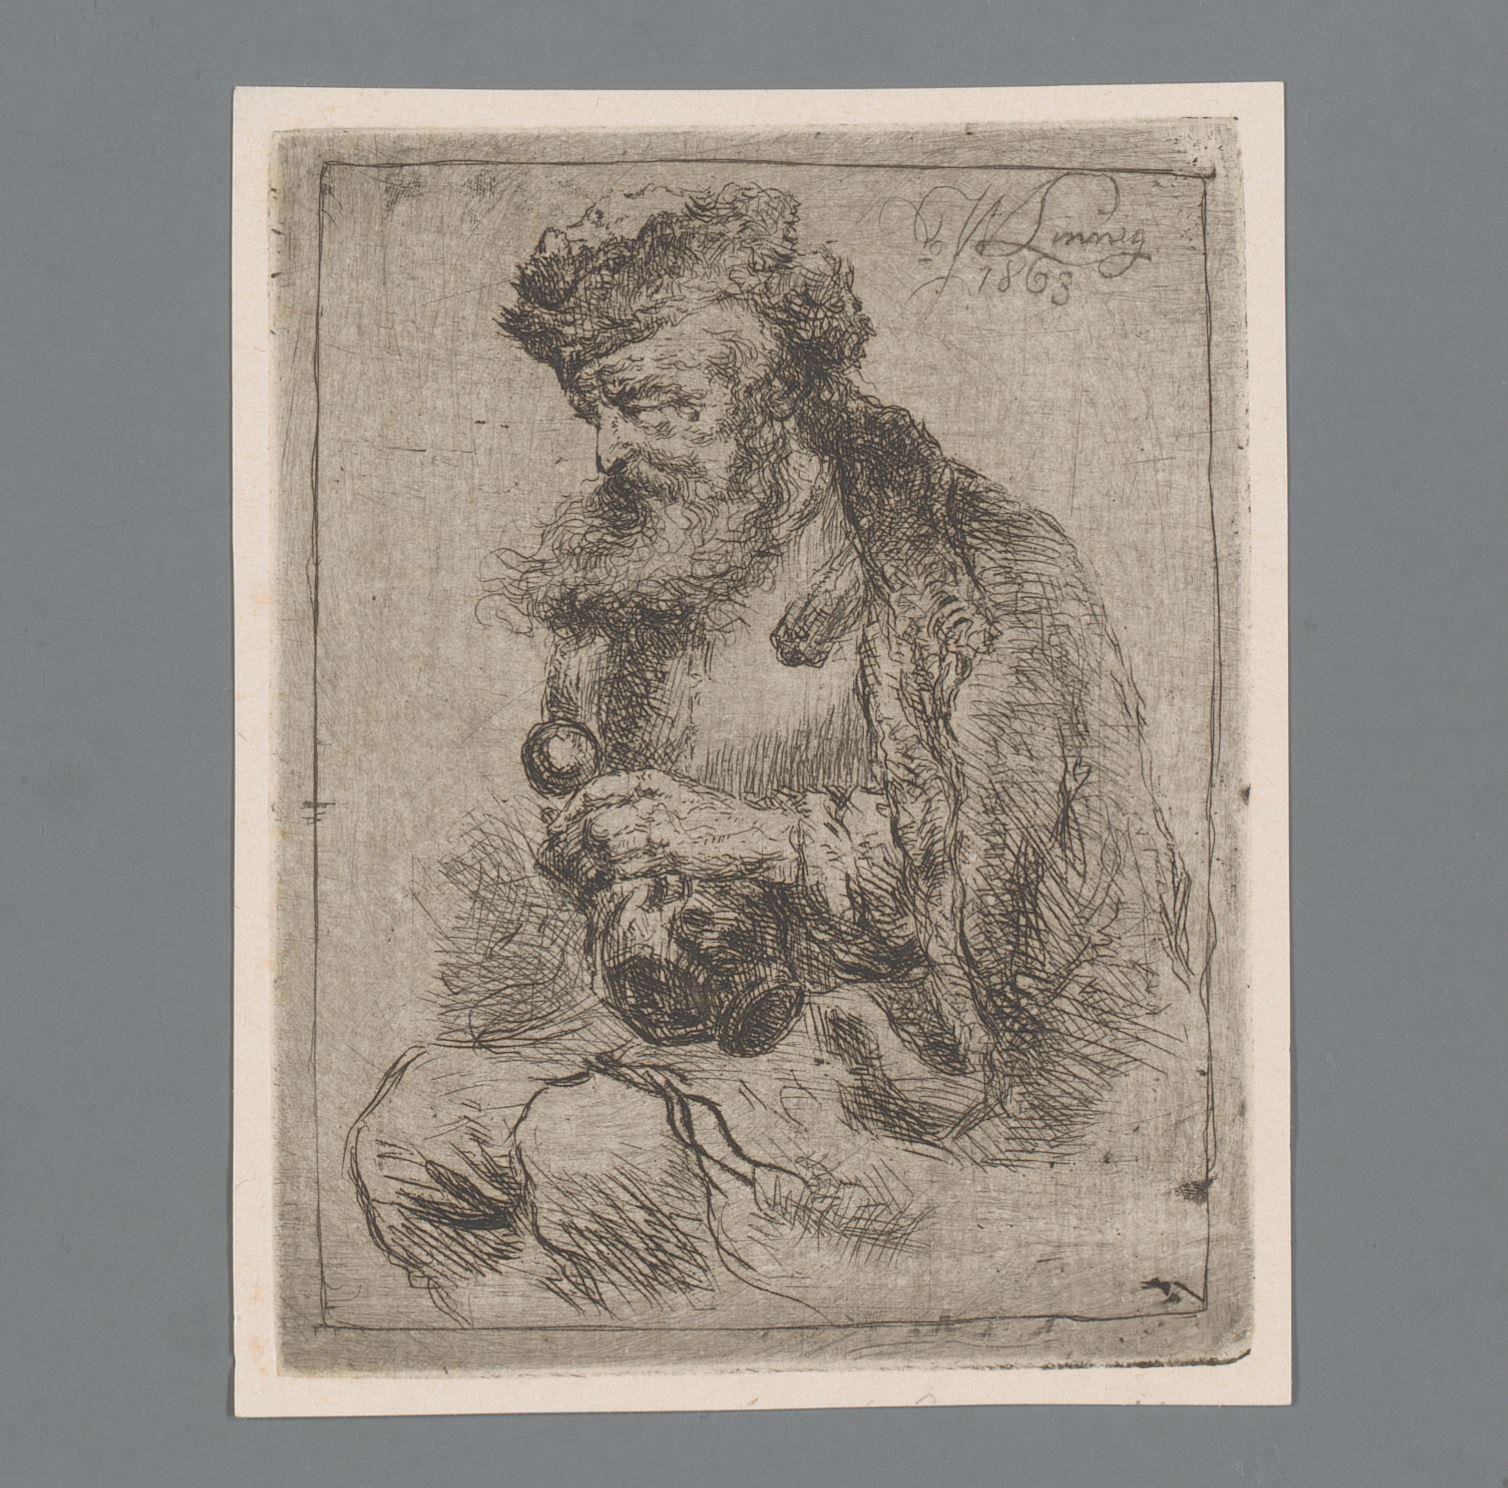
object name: print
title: Bebaarde man met een kruik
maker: willem linnig (ii)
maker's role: print maker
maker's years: 1842-1890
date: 1863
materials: paper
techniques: etching, intaglio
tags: jar, jug (used as drinking-vessel), old man, beard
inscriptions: collector's mark: Lugt 2228